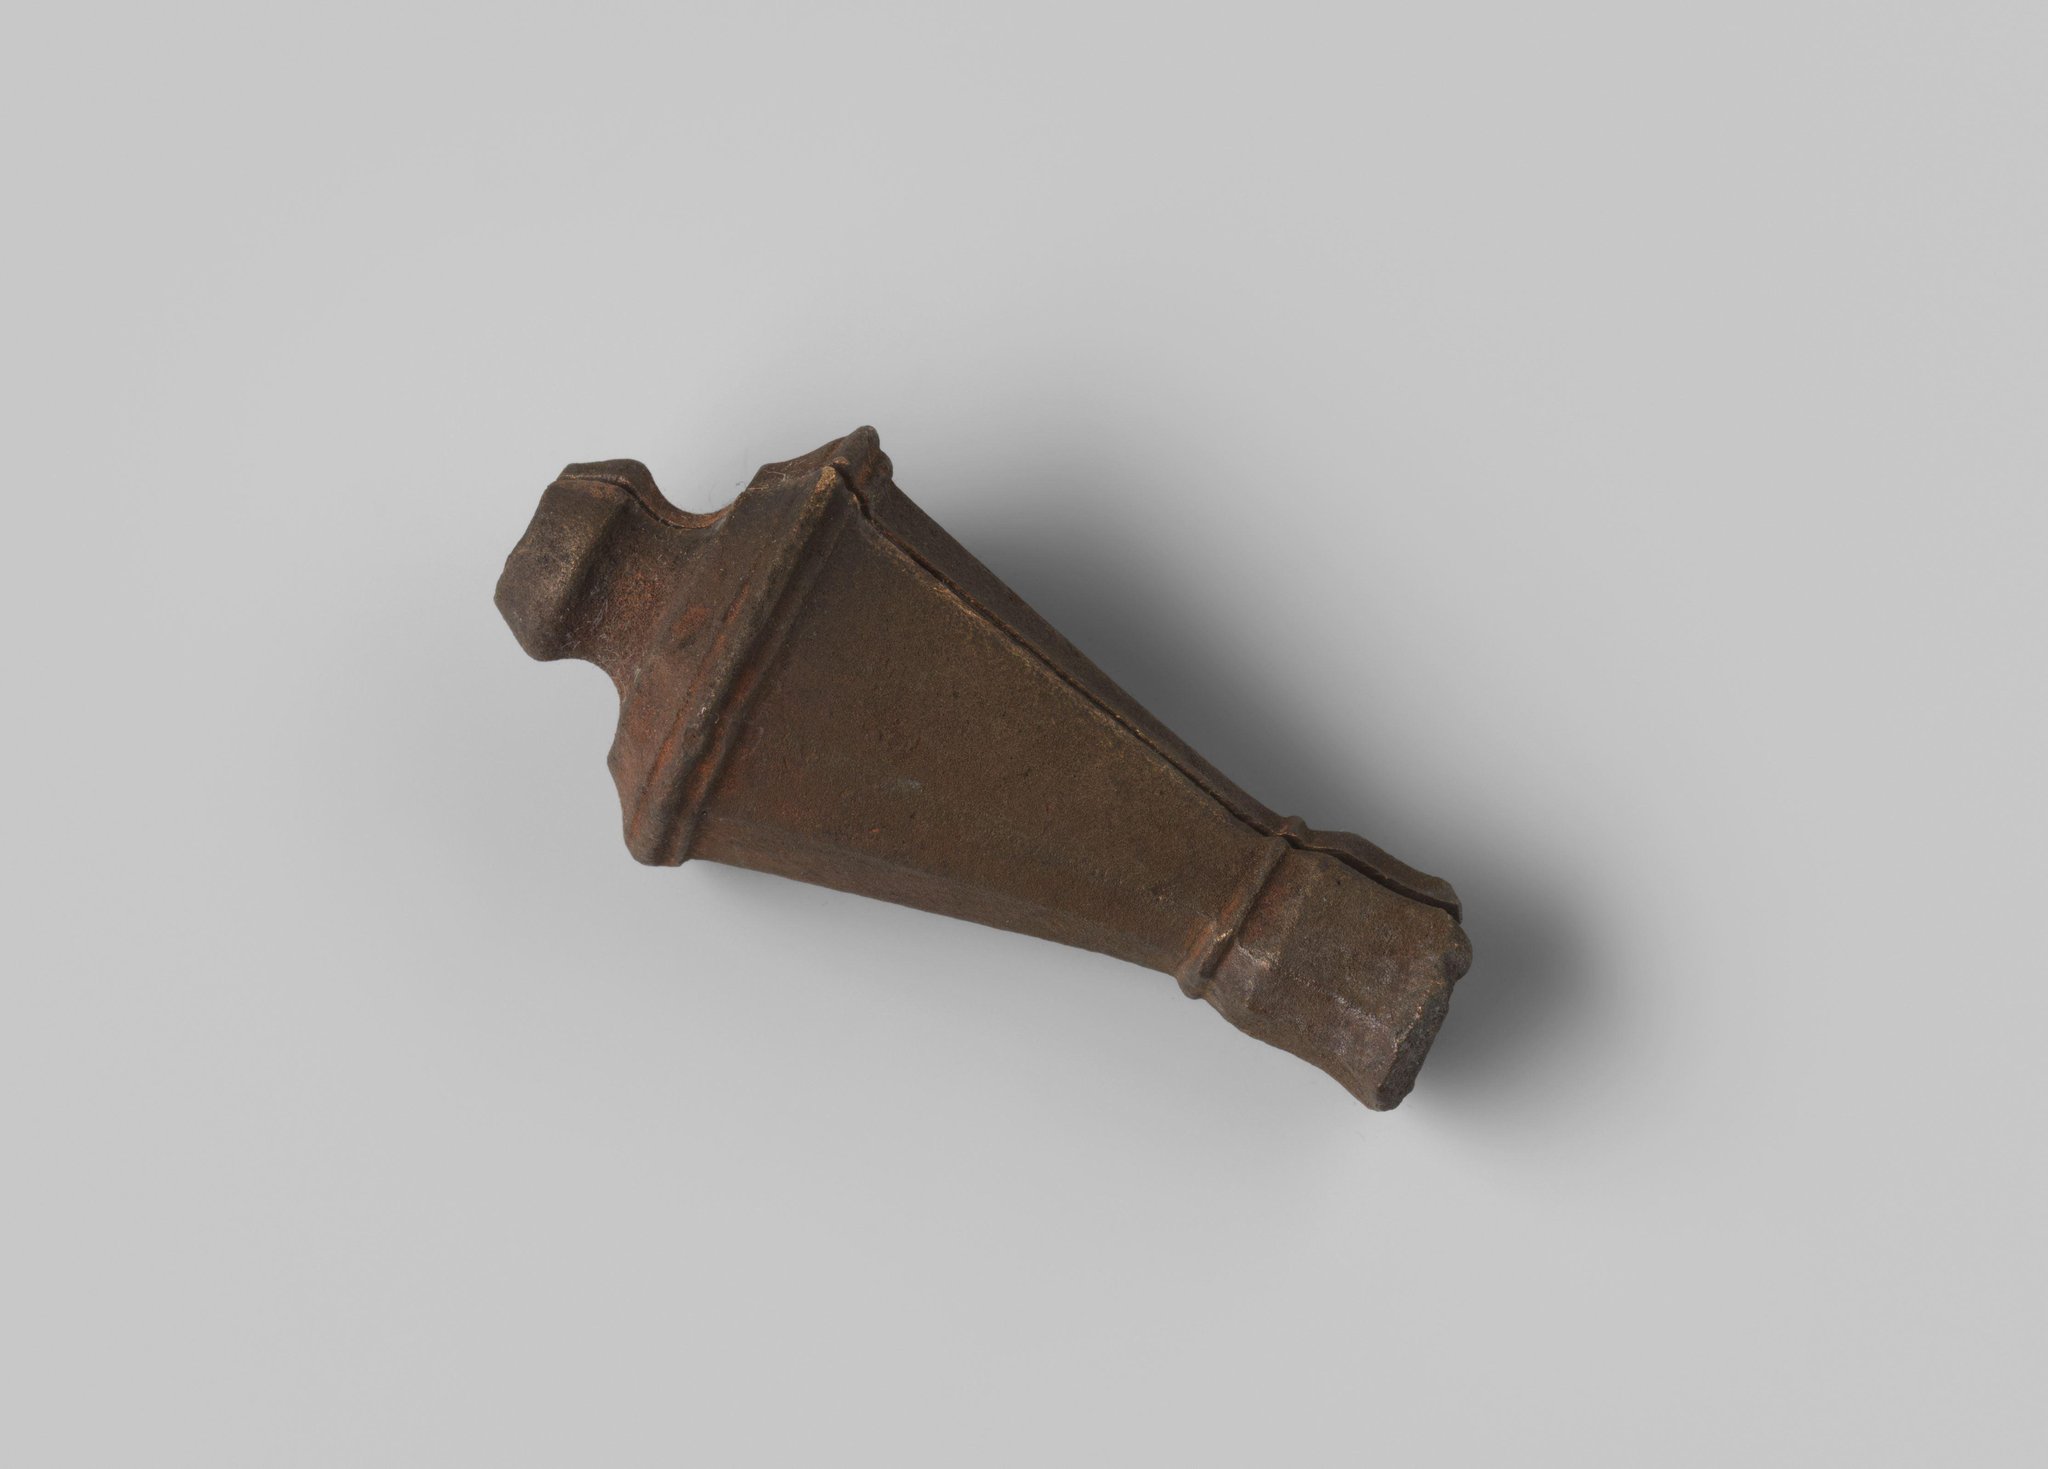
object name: candlestick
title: Steel van een kandelaar uit het wrak van de Oost-Indiëvaarder Hollandia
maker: Anonymous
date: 1700-1743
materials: copper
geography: netherlands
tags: verenigde oostindische compagnie, hollandia (schip), annet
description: Candlestick, stem; fragm, inverted baluster-shaped, octagonal faceted with 4 long and 4 short sides, hollow, flattened knop on upper end, both ends broken off.